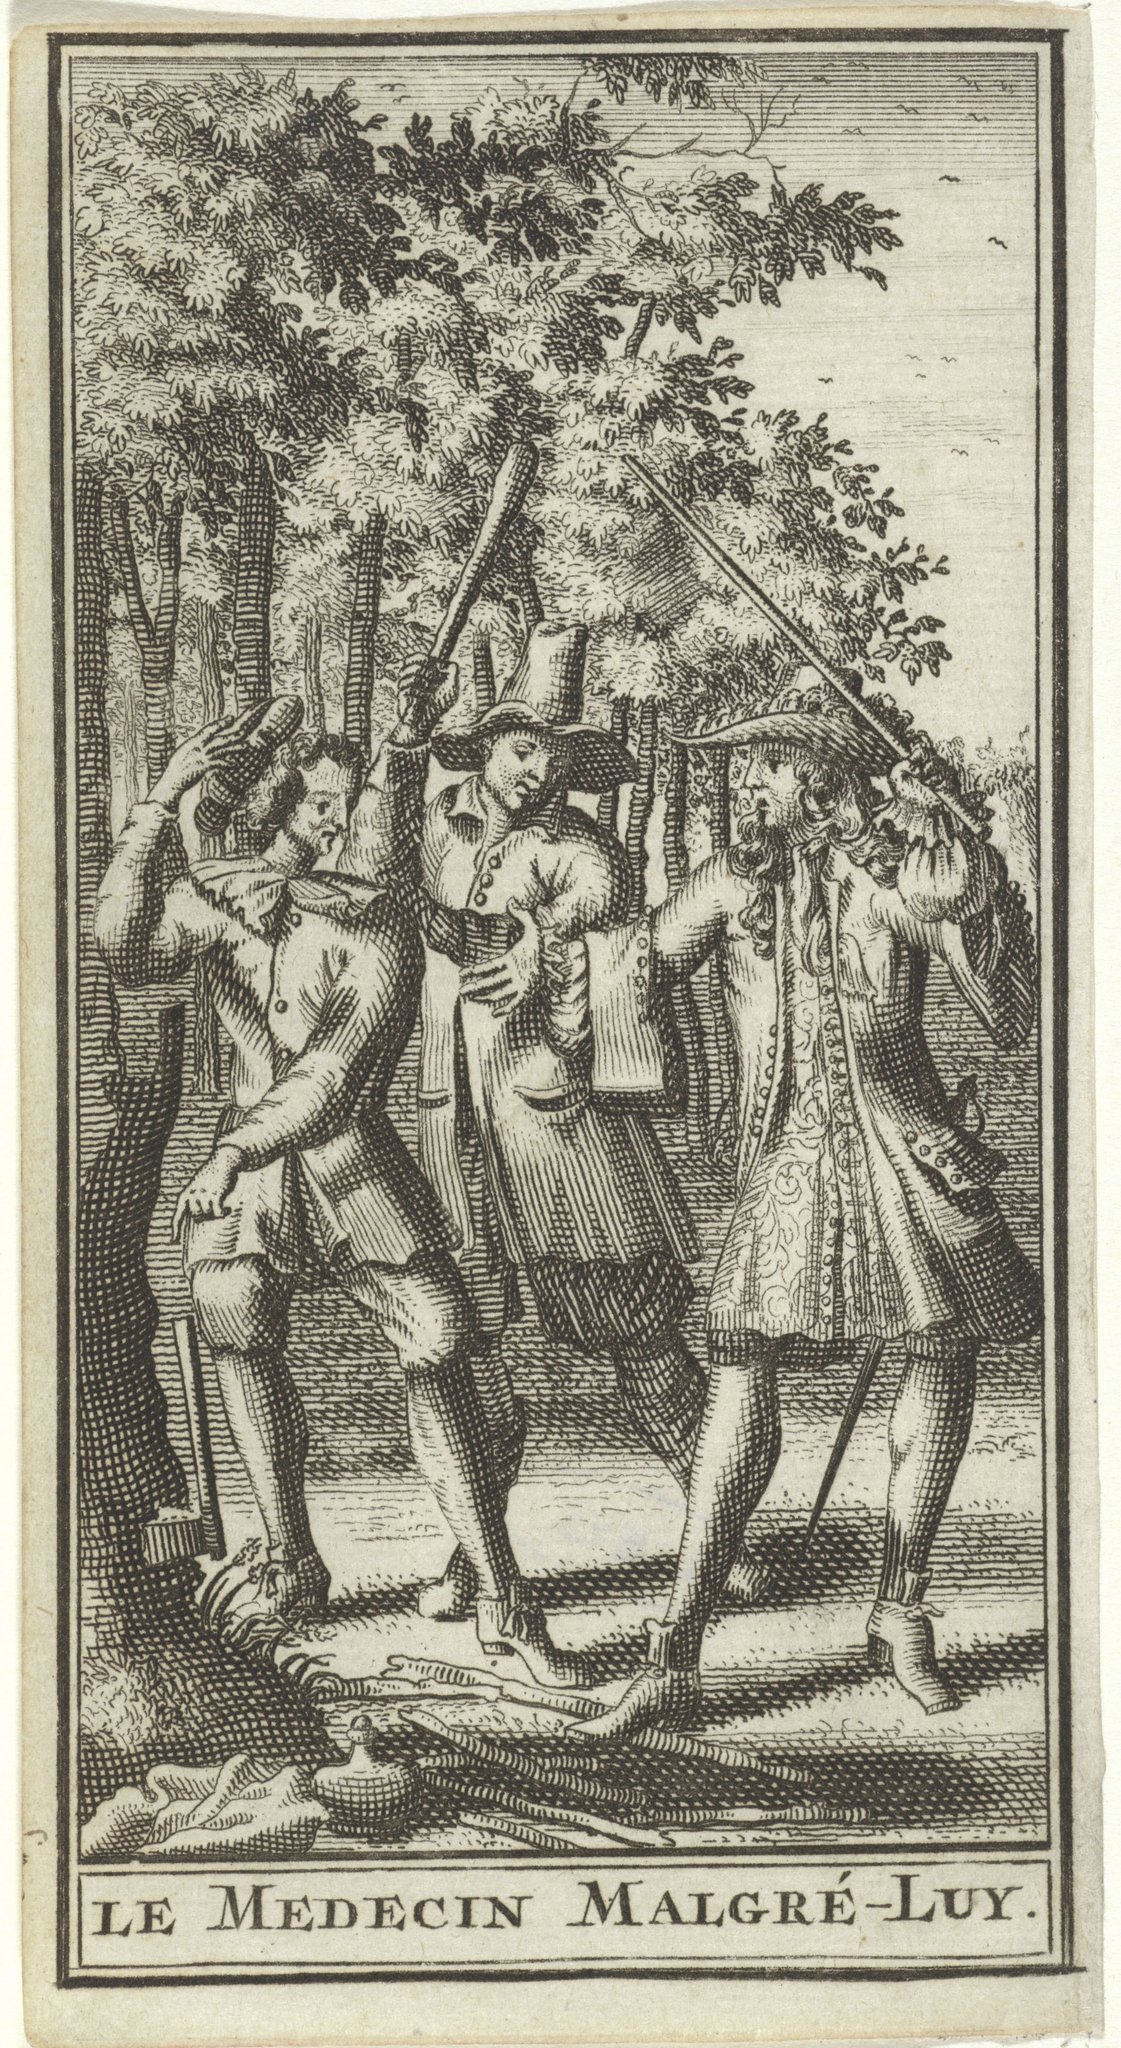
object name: book illustration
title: Le medecin malgré-luy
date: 1713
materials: paper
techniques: etching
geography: utrecht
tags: woodcutting, woodcutter ~ forestry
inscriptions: collector's mark: Lugt 2228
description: Illustratie voor: Moliere. Les oeuvres. 4 delen, Amsterdam, P. Brunel , Amsterdam, D. Mortier, Utrecht, G. van de Water, 1713.